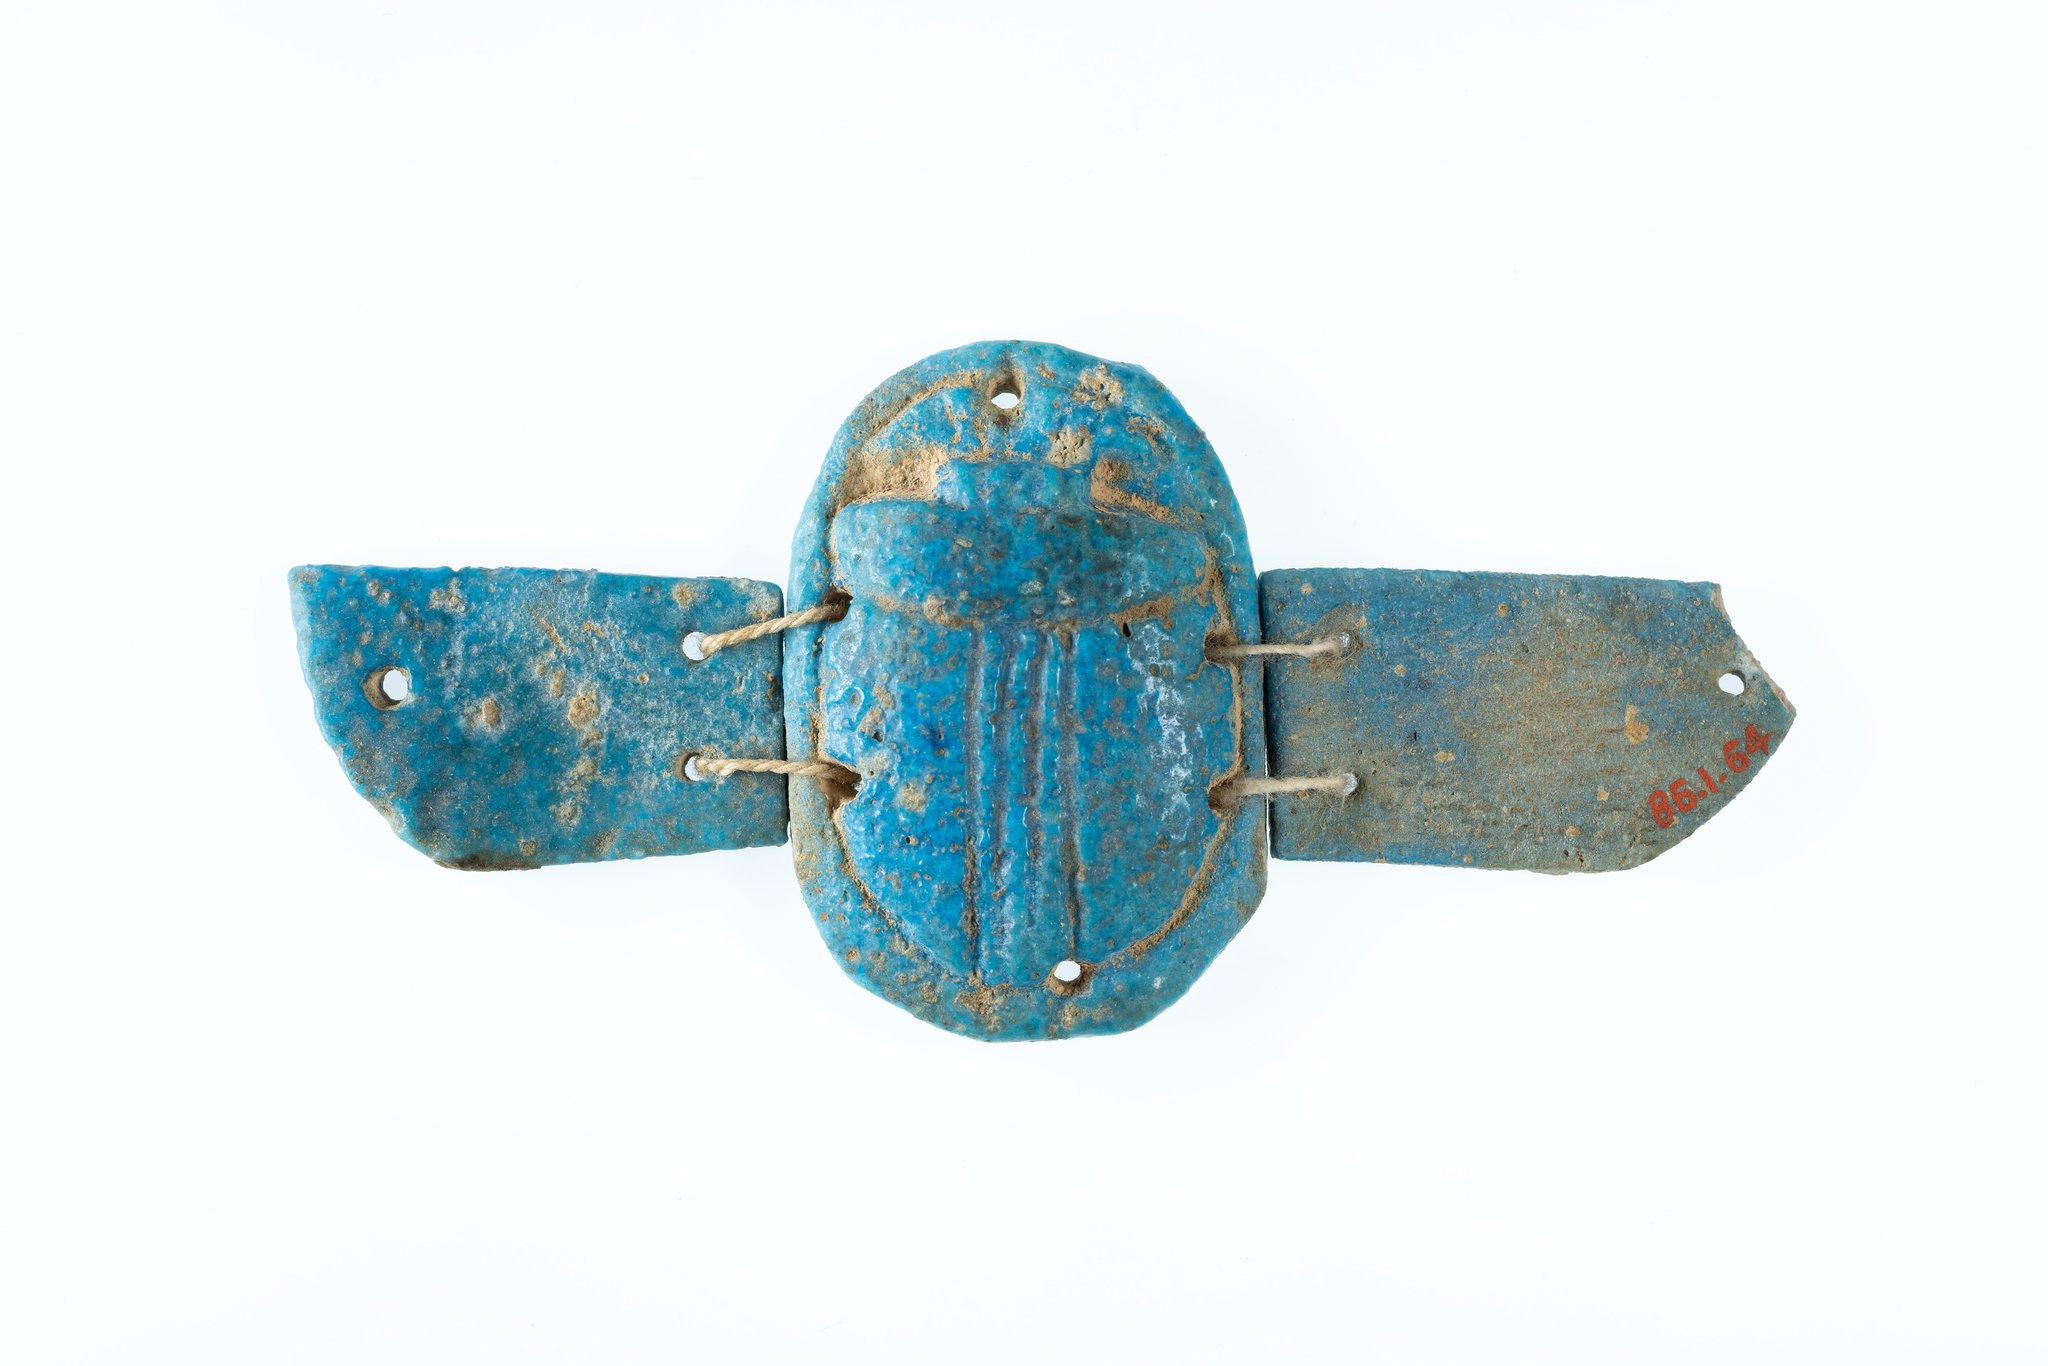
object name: amulet, winged scarab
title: Winged scarab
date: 664-630 BCE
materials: faience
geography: egypt